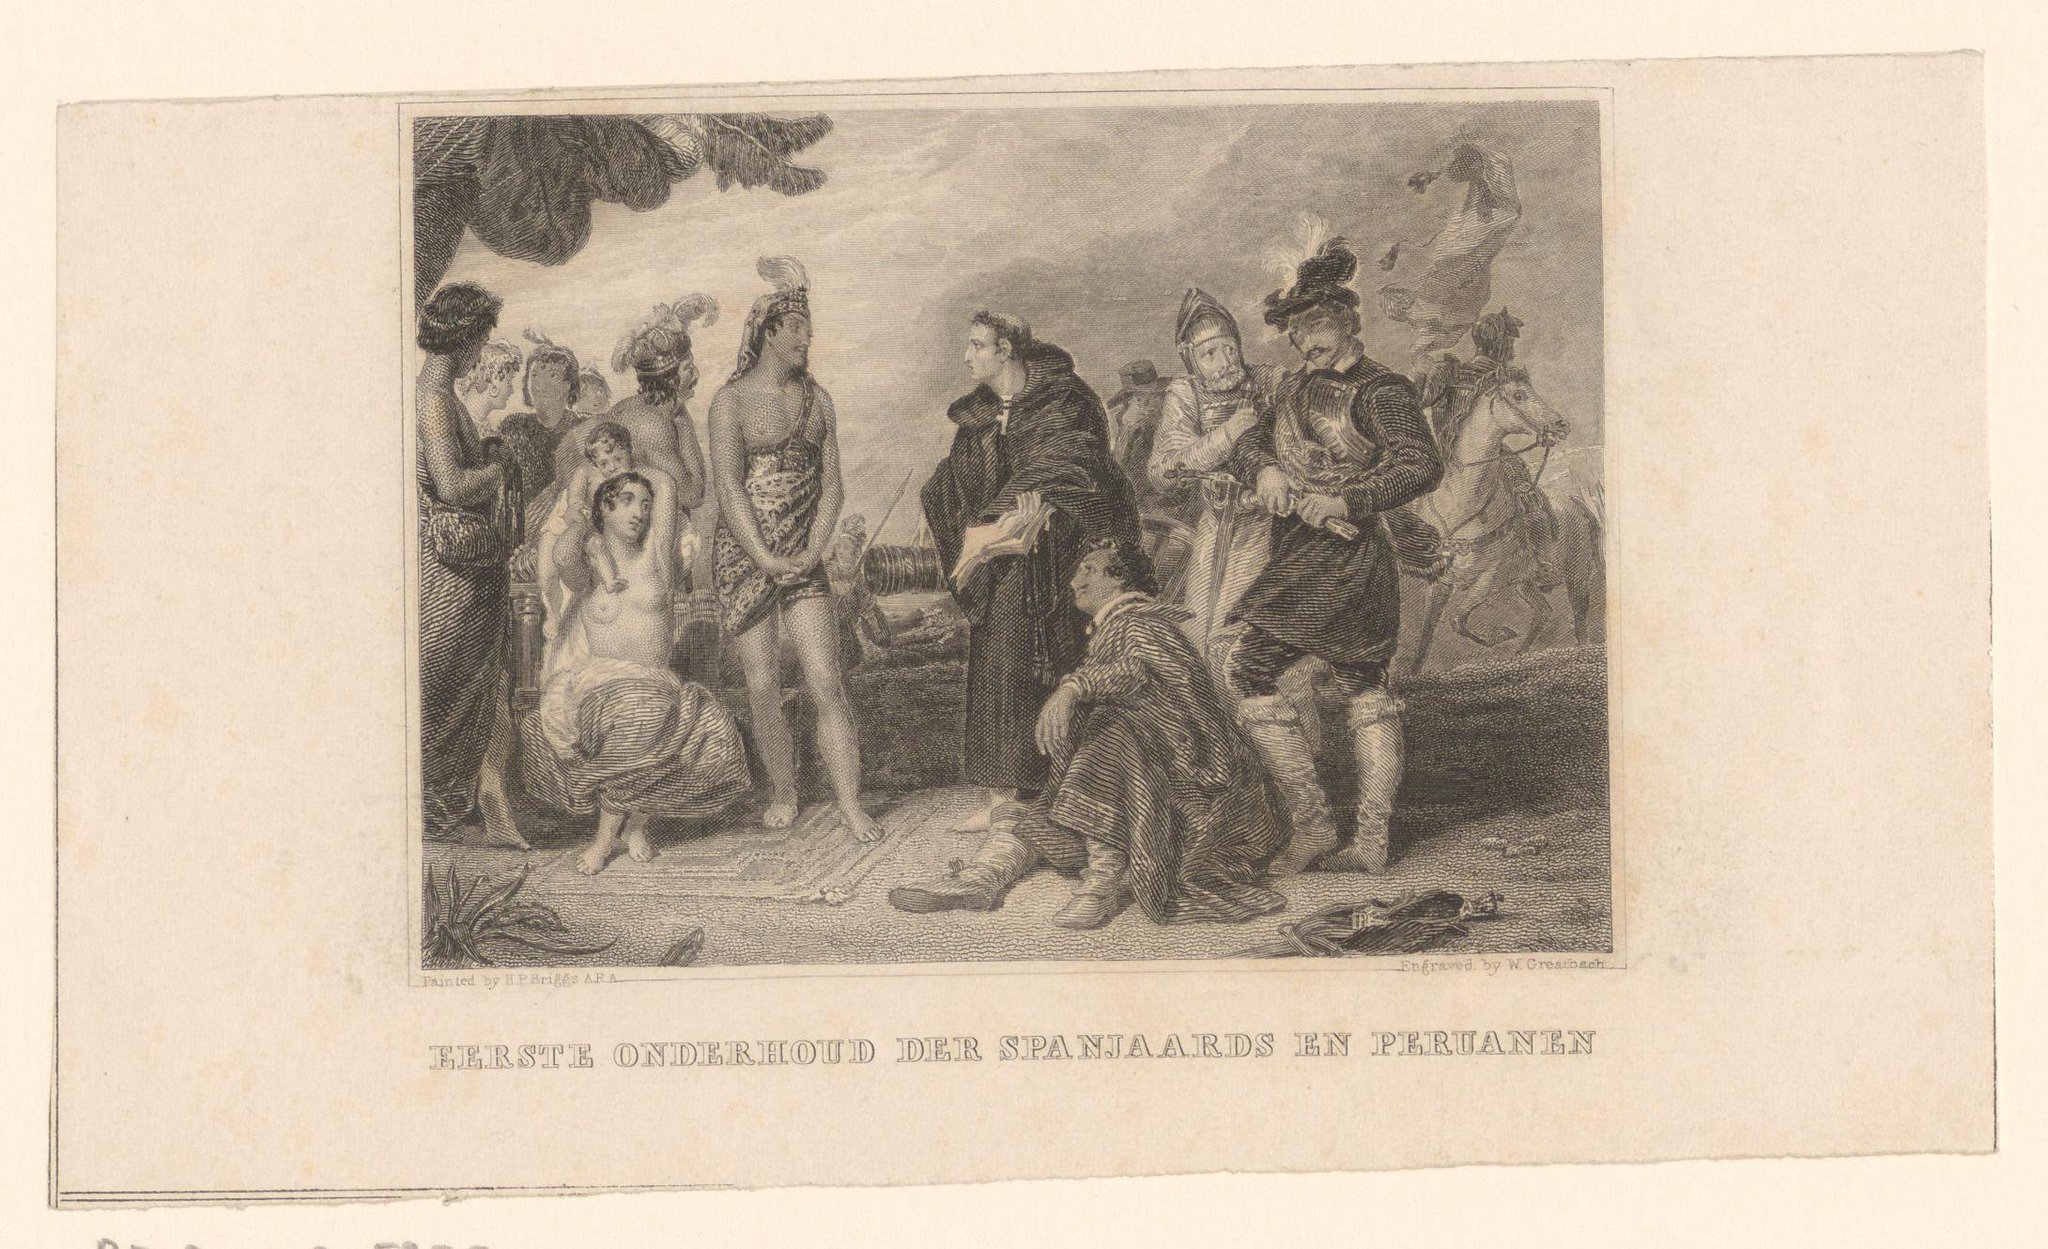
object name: print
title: Eerste onderhoud der Spanjaards en Peruanen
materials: paper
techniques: etching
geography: london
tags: monk(s), friar(s)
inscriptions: collector's mark: Lugt 2228